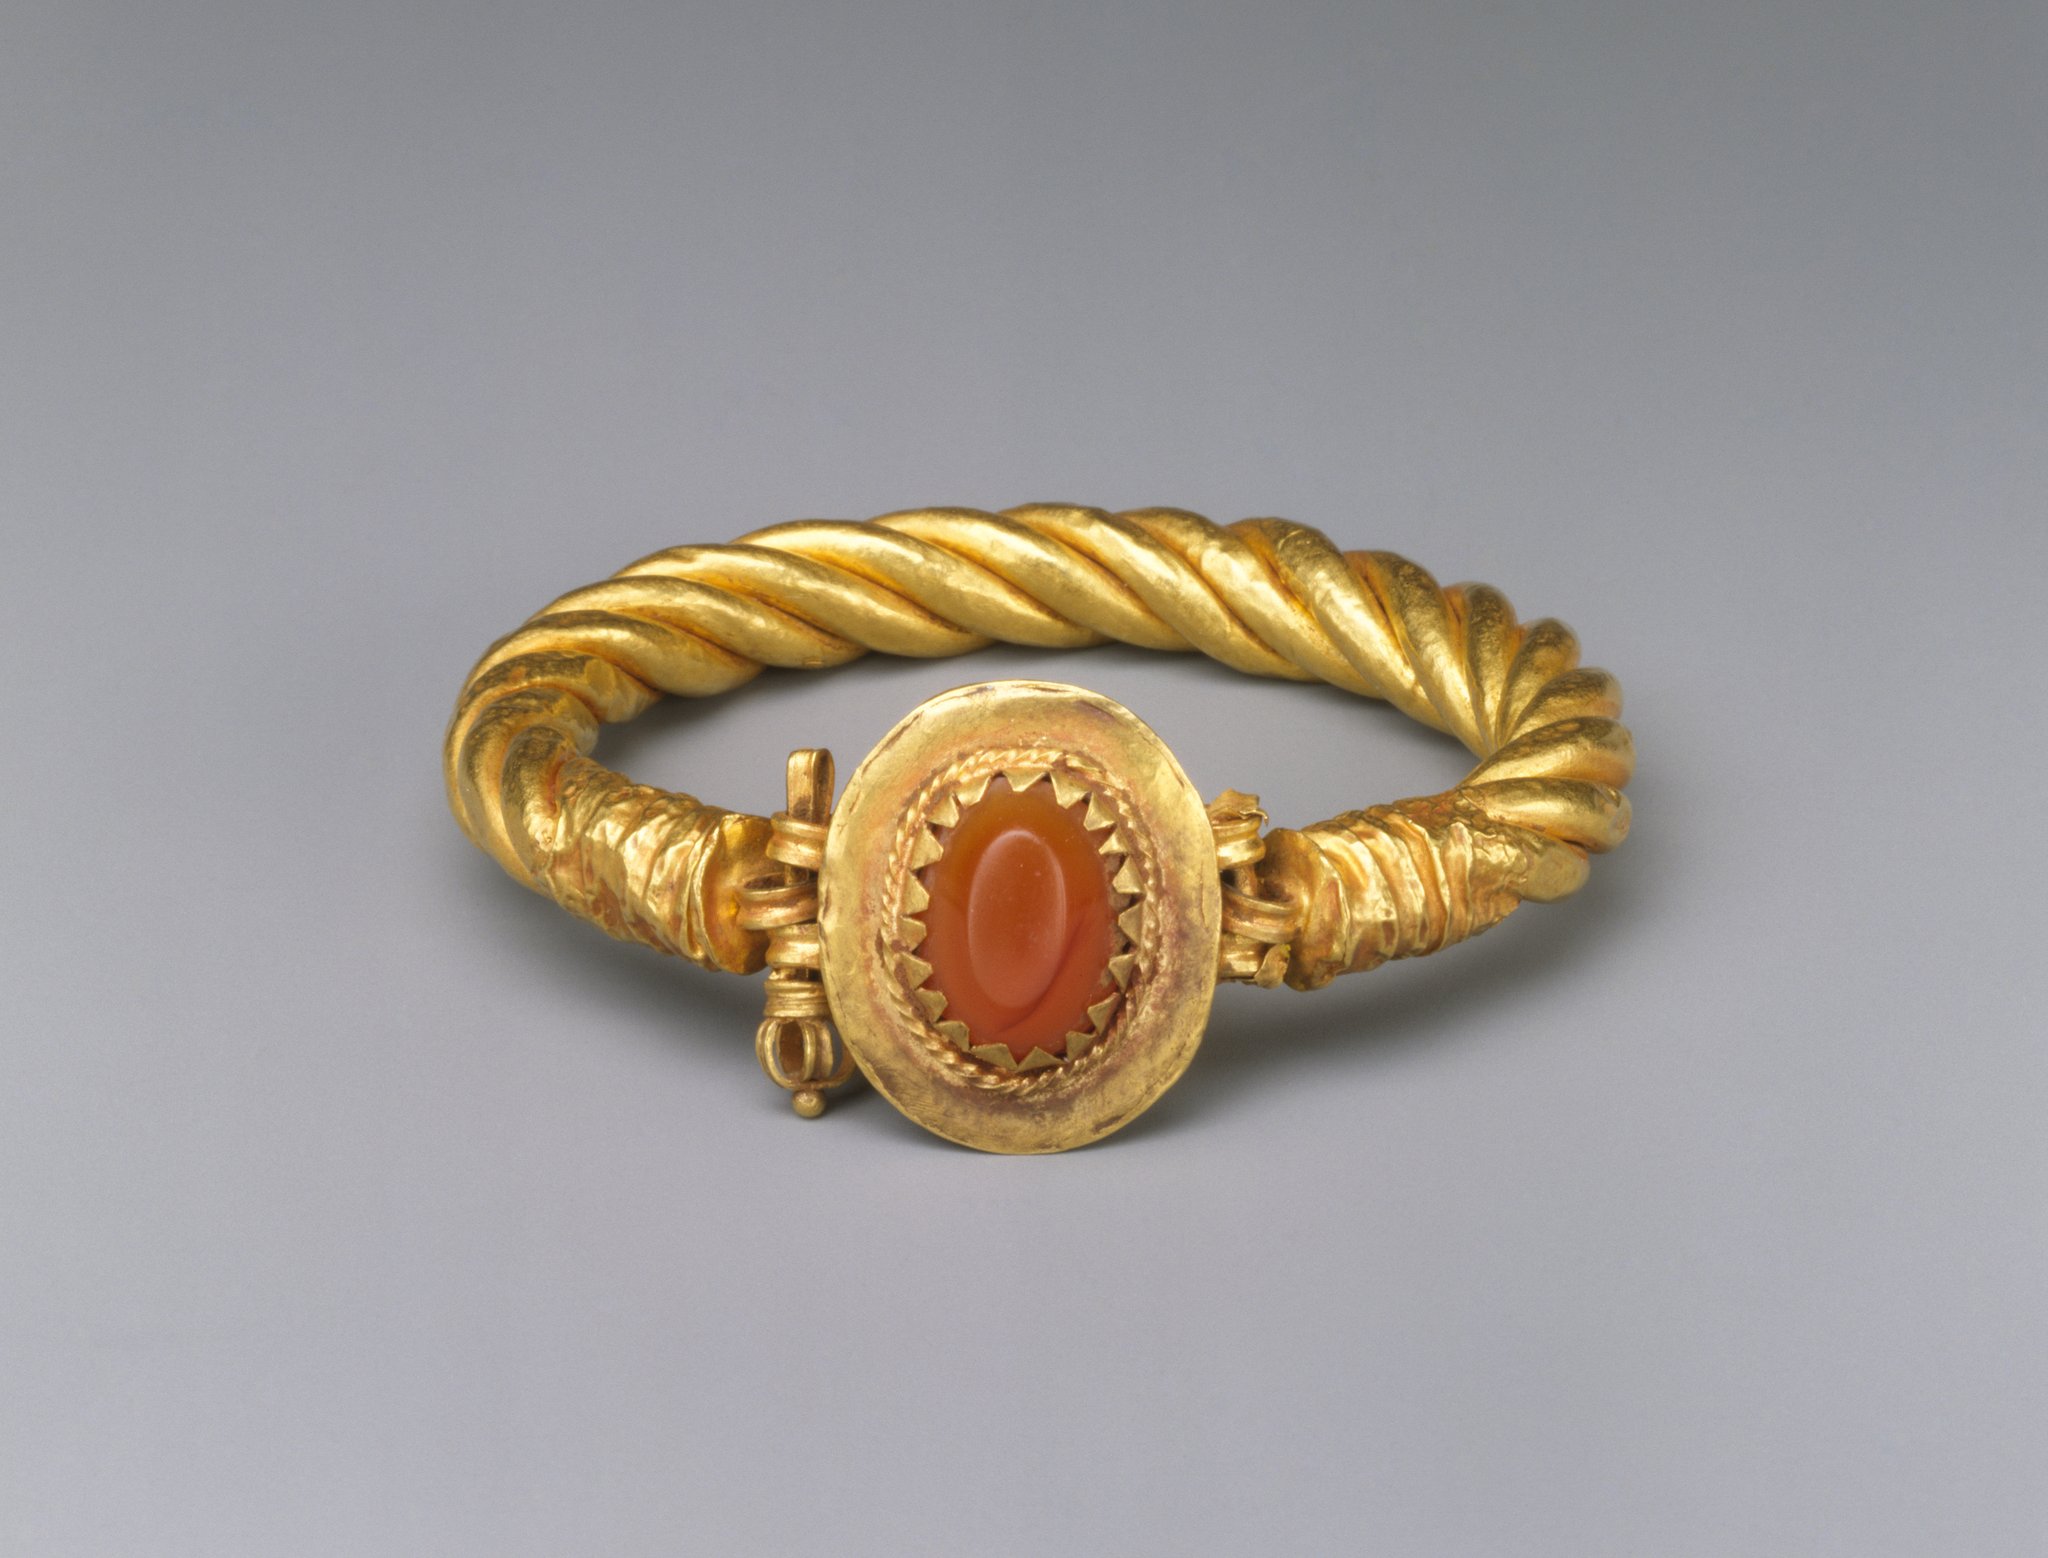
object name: bracelet with carnelian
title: Gold bracelet with a carnelian stone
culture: roman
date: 201-300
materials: gemstone, gold